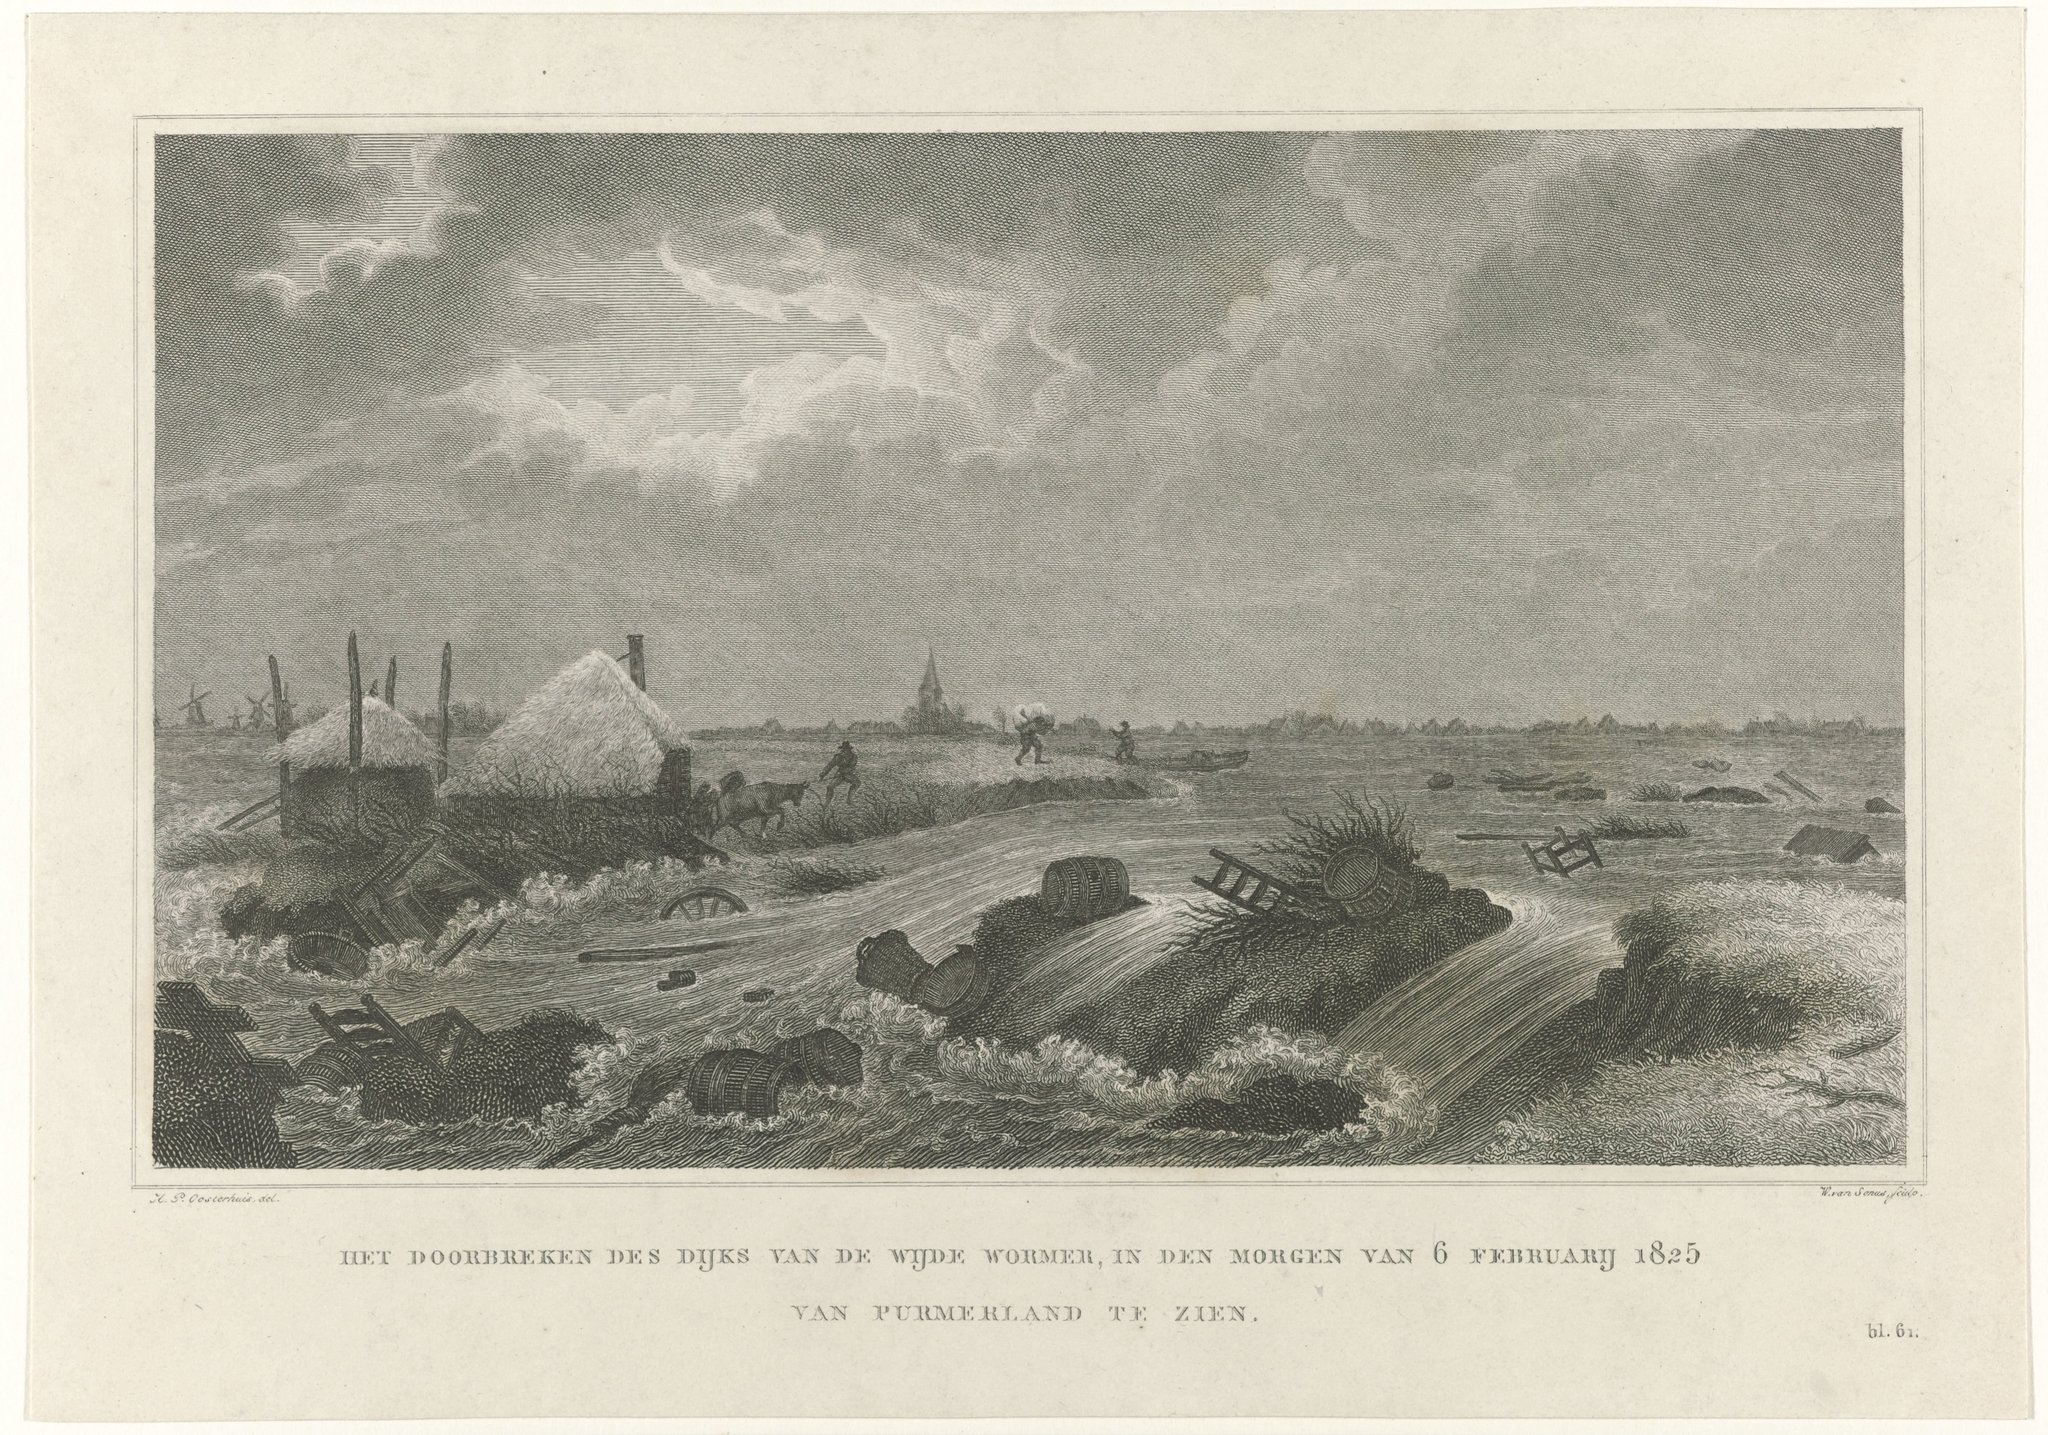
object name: print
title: Dijkdoorbraak bij de Wijde Wormer, 1825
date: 1825-1826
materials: paper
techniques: engraving, etching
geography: netherlands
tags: flood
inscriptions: collector's mark: Lugt 2228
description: Gebruikt als illustratie in: Nicolaas Swart, Historisch tafereel van den zwaren watersnood, op den 3den, 4den en 5den Februarij 1825, een groot deel van ons vaderland hebbende getroffen. Amsterdam : bij Schalekamp en Van de Grampel, 1826, p. 61.